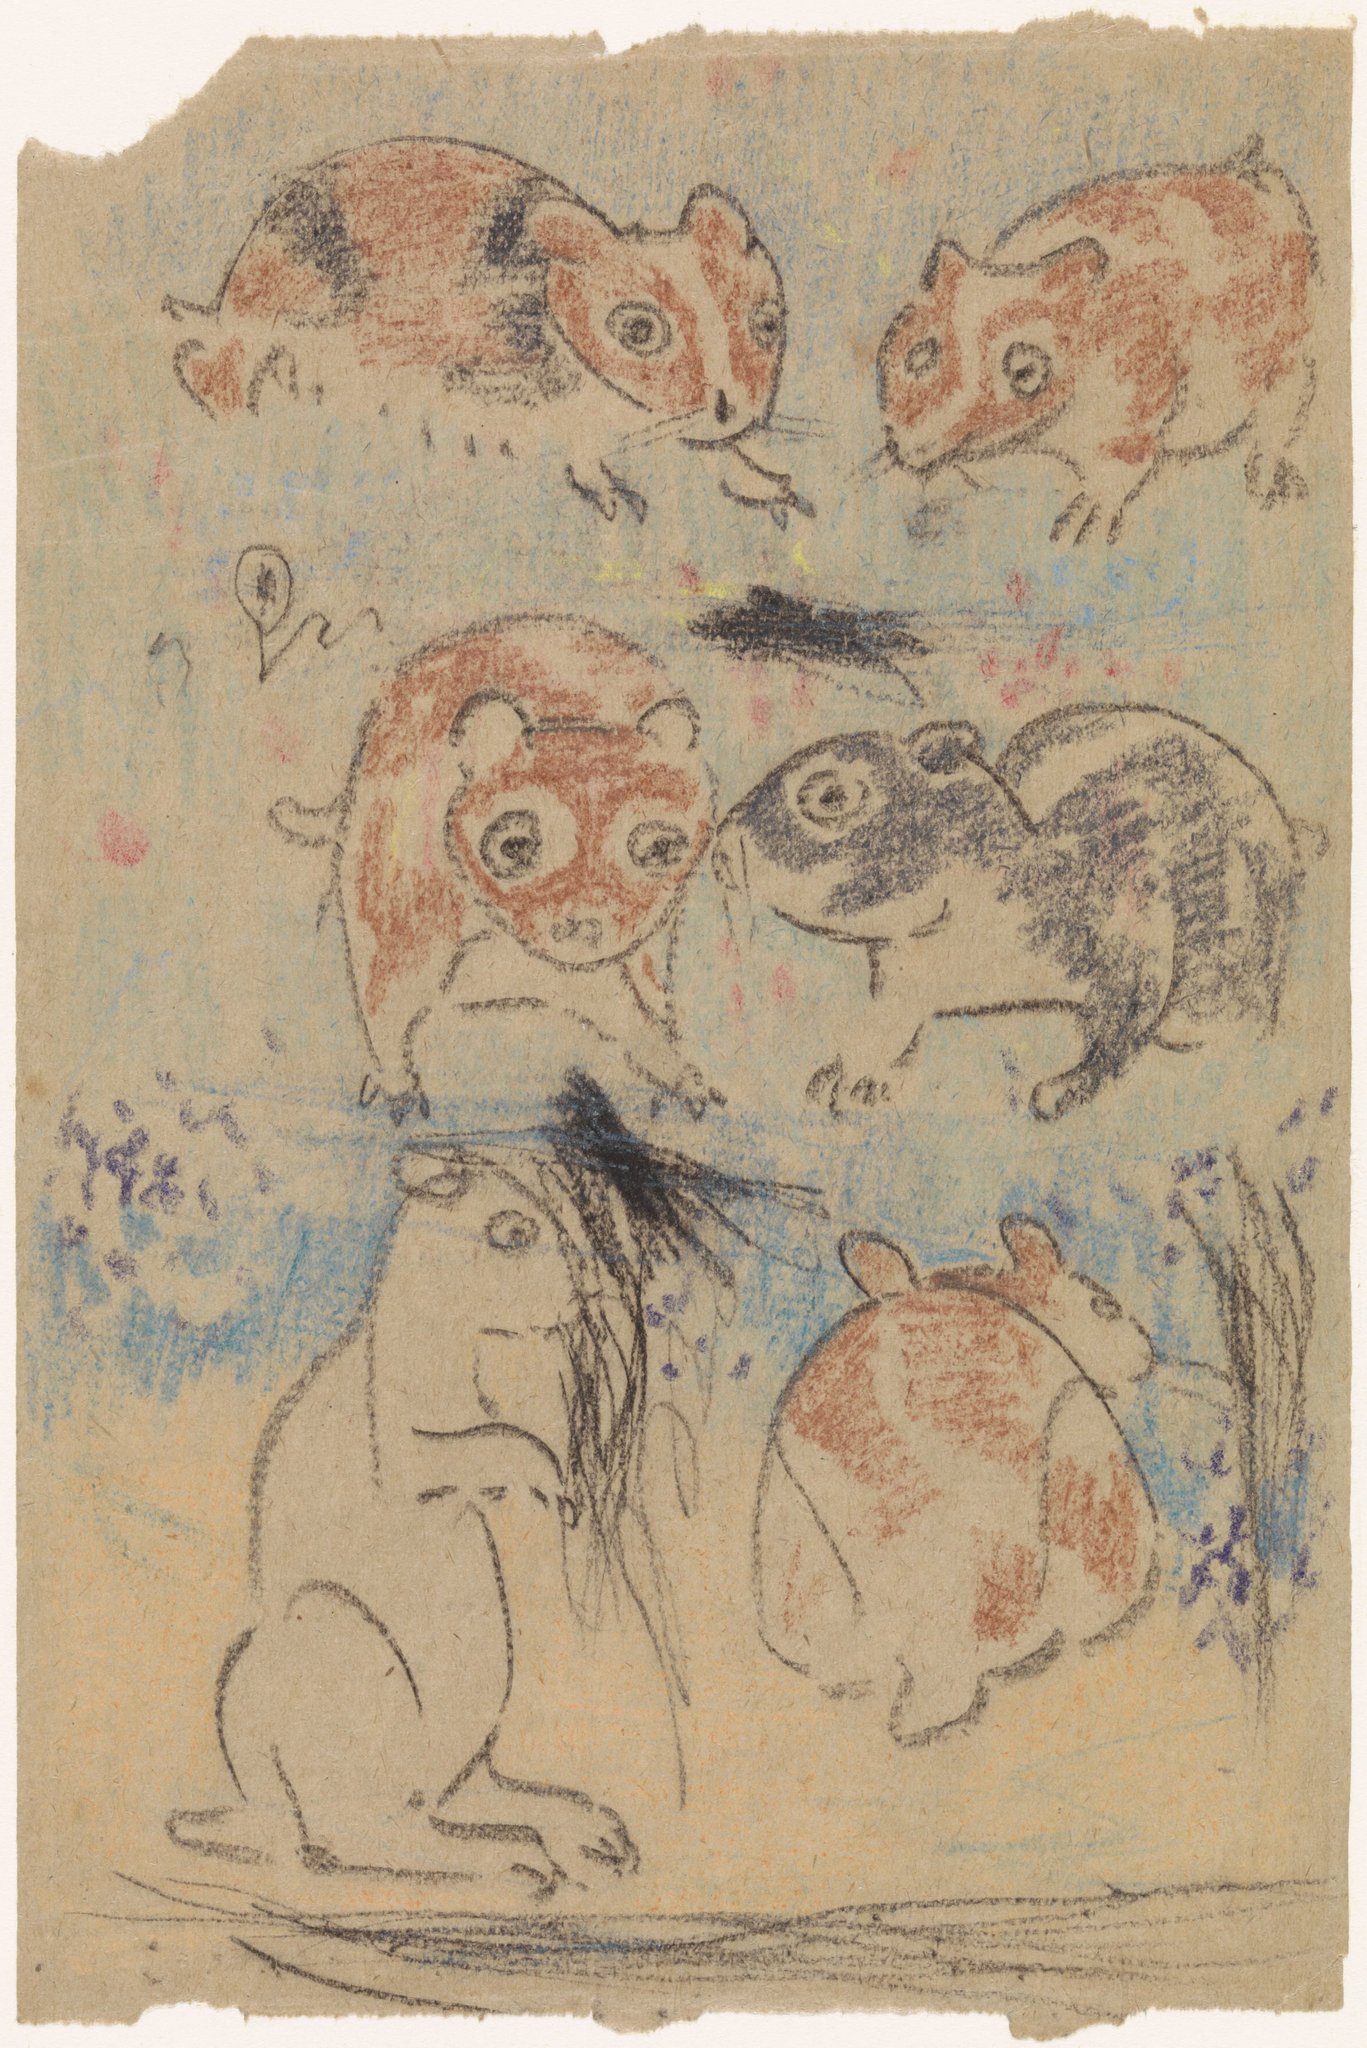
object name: schetsblad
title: Studies van marmotten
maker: gerrit willem dijsselhof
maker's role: designer, draughtsman, print maker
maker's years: 1866-1924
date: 1876-1924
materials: chalk, paper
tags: rodents: marmot